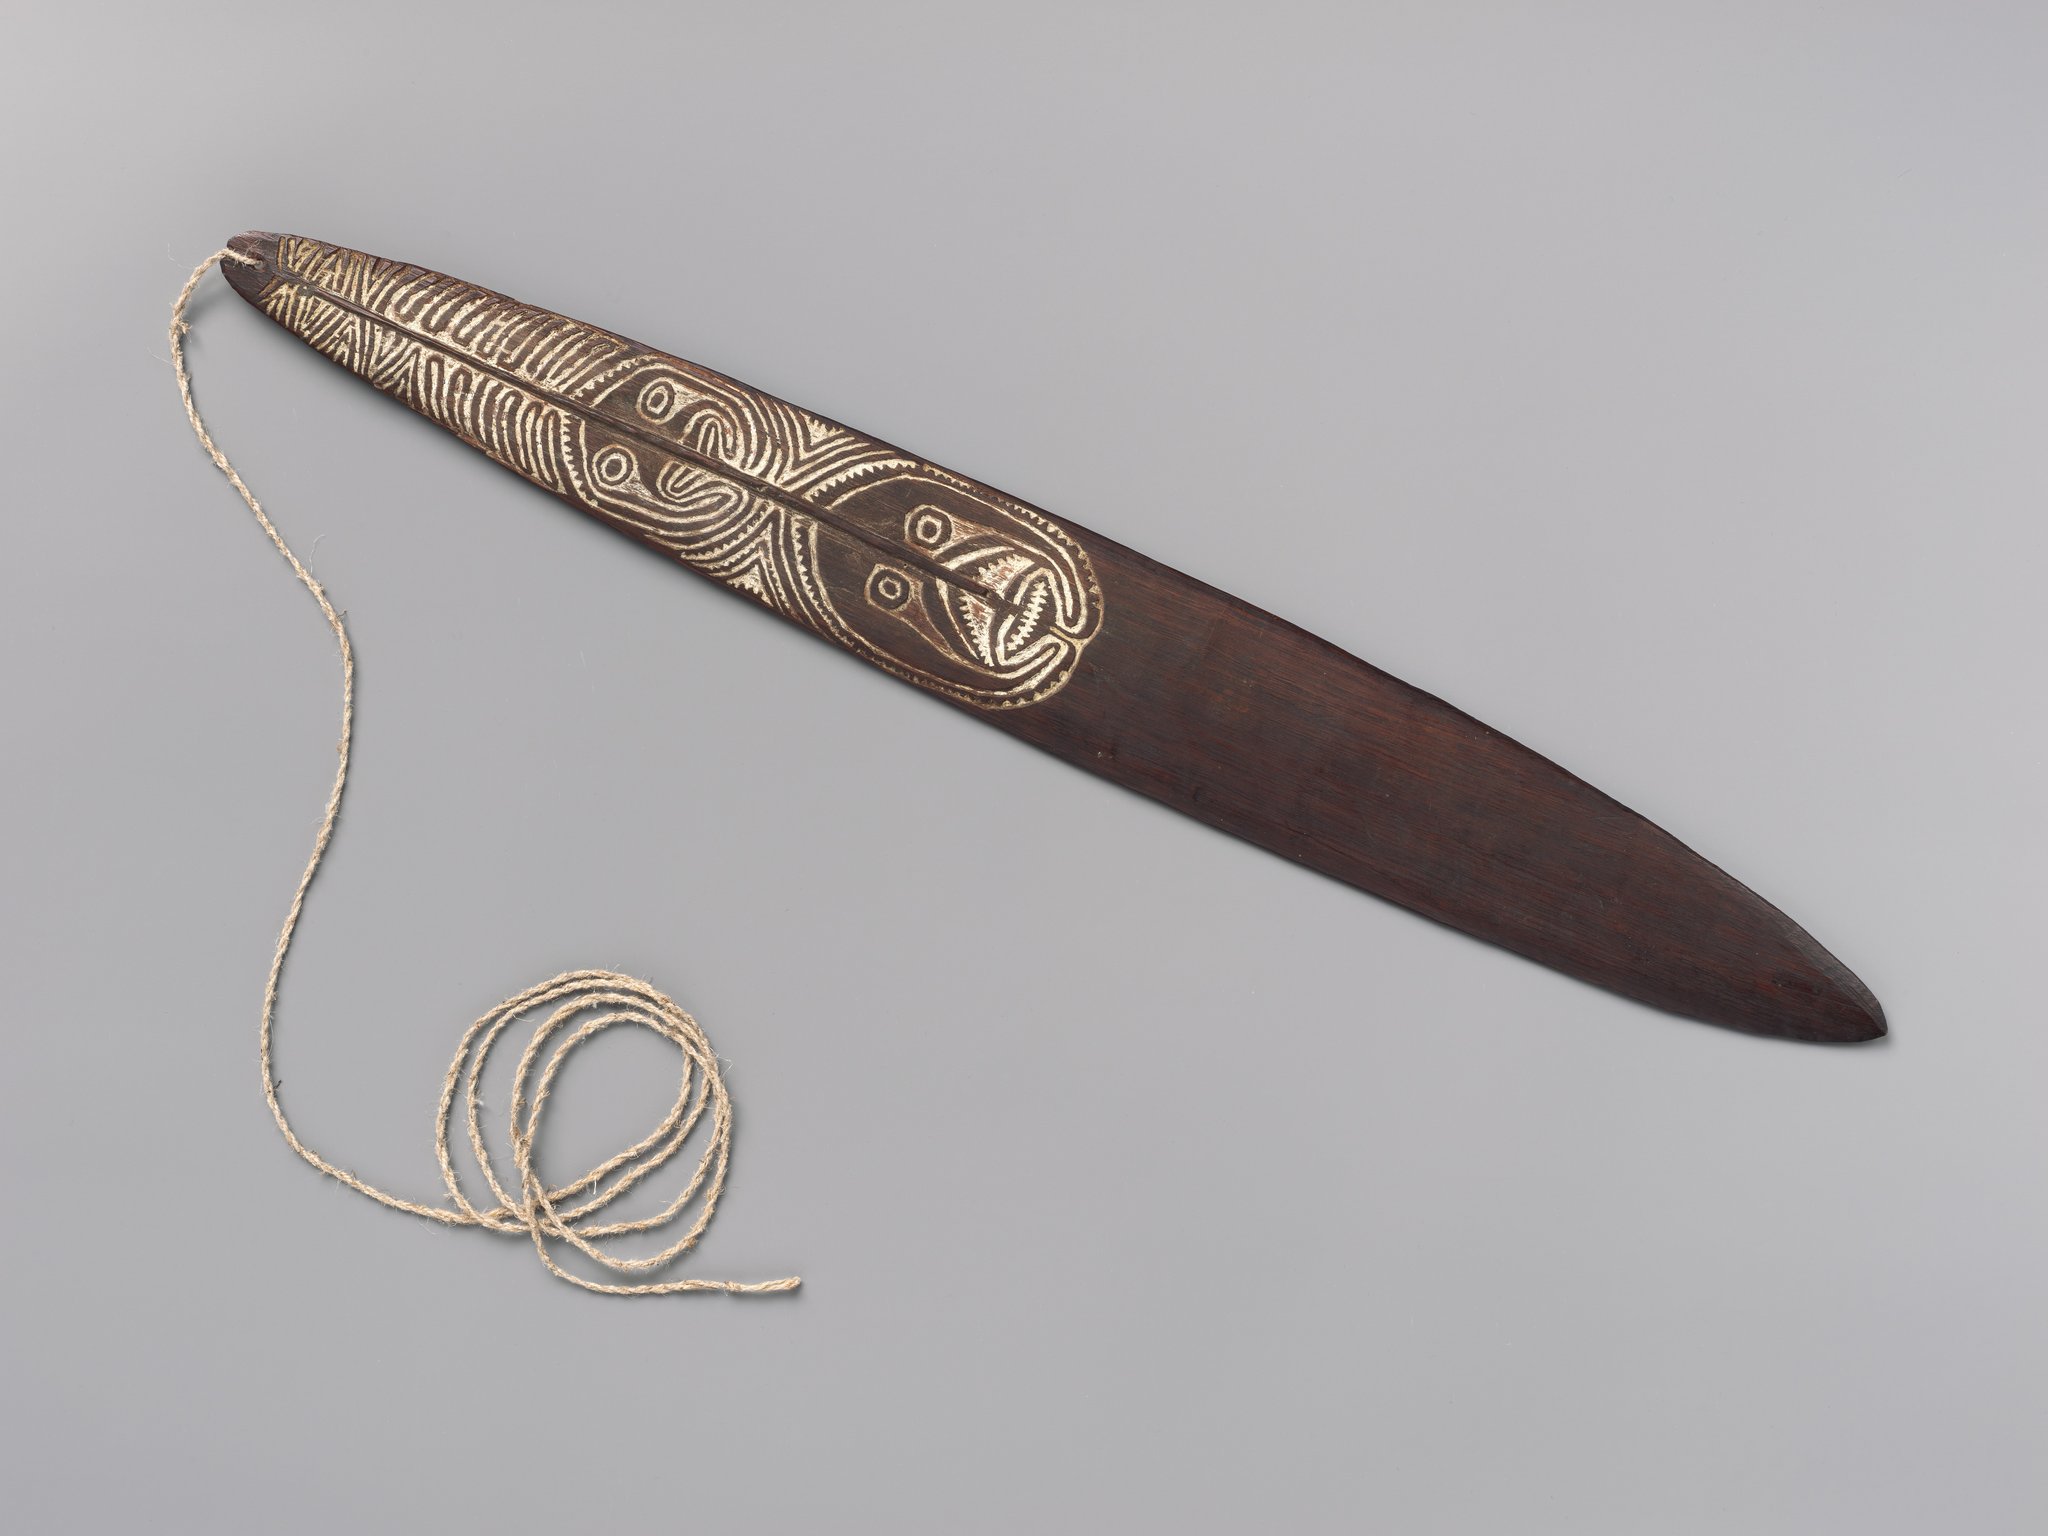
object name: bullroarer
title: Bullroarer (Imunu Viki?)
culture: papua new guinean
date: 1867-1900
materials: wood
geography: papua new guinea